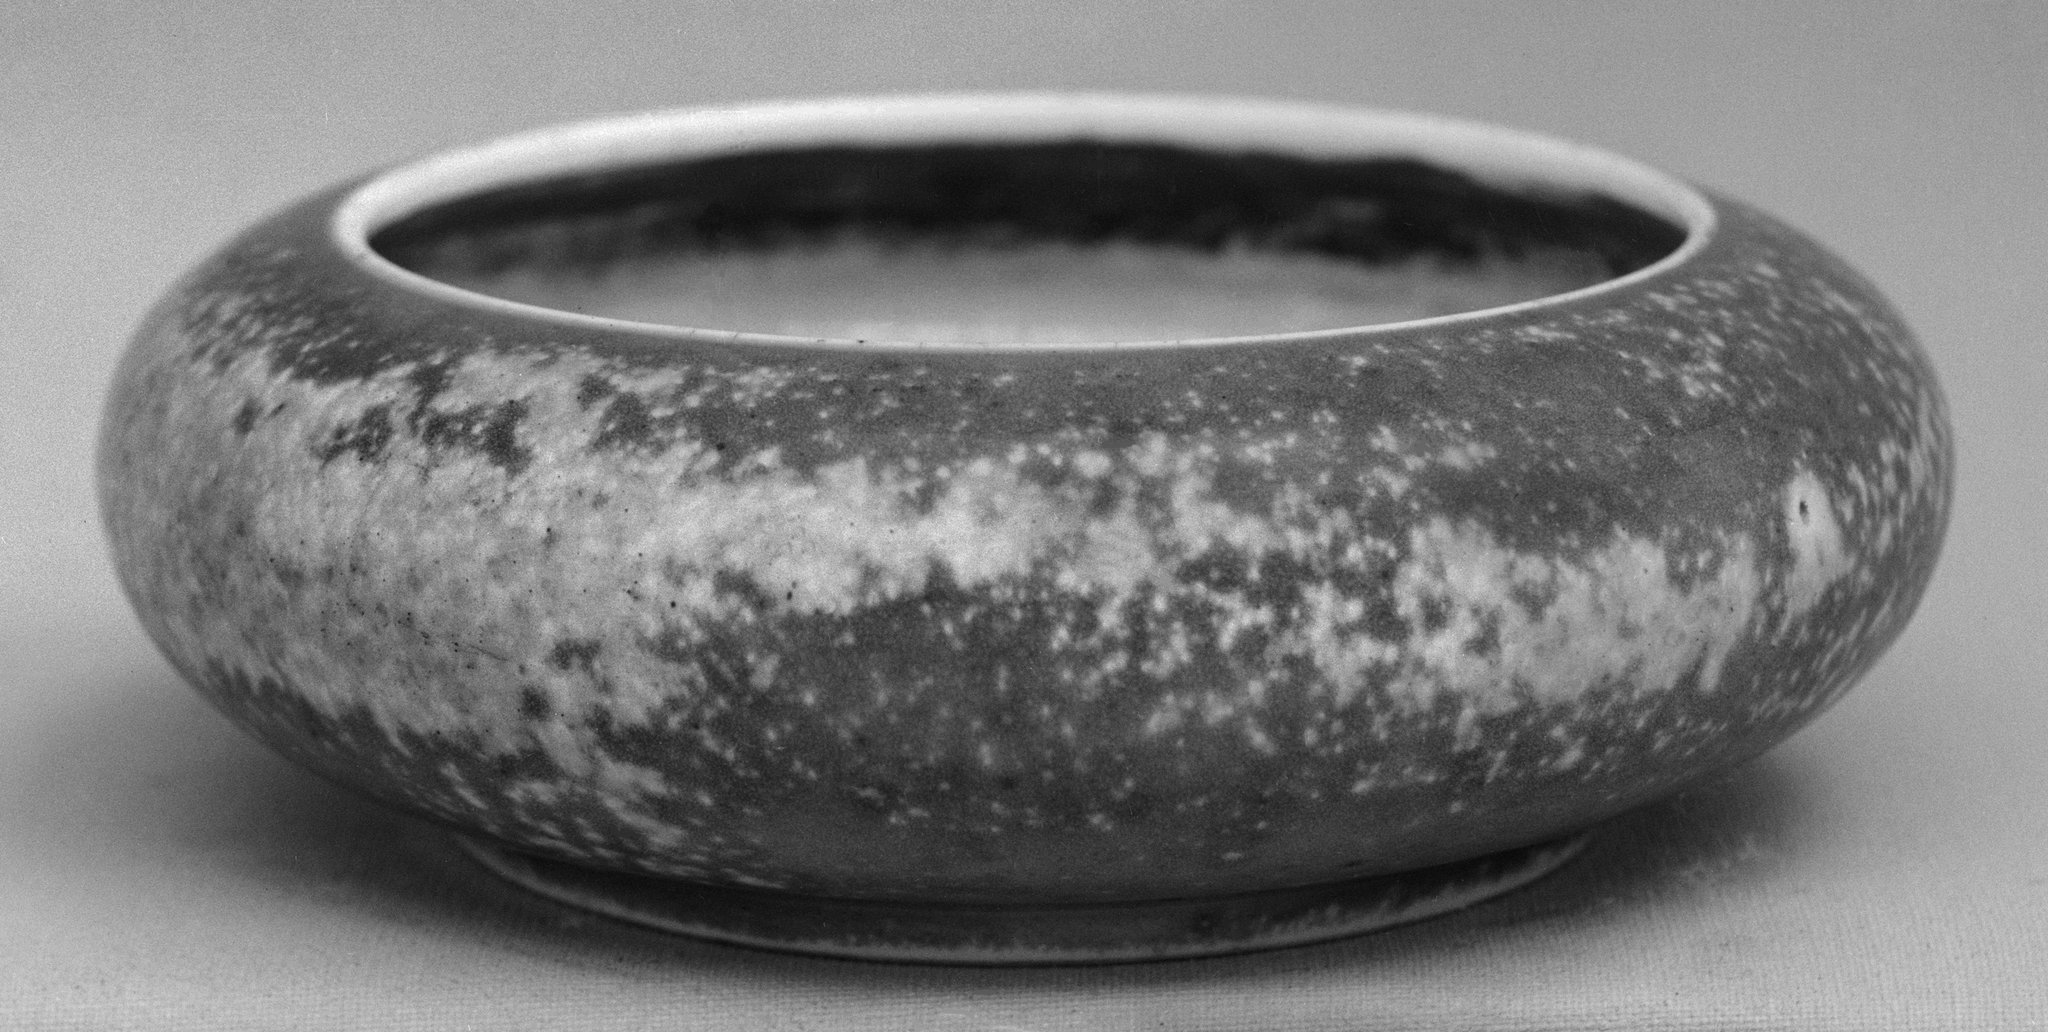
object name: brush washer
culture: chinese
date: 1667-1733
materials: glaze, porcelain